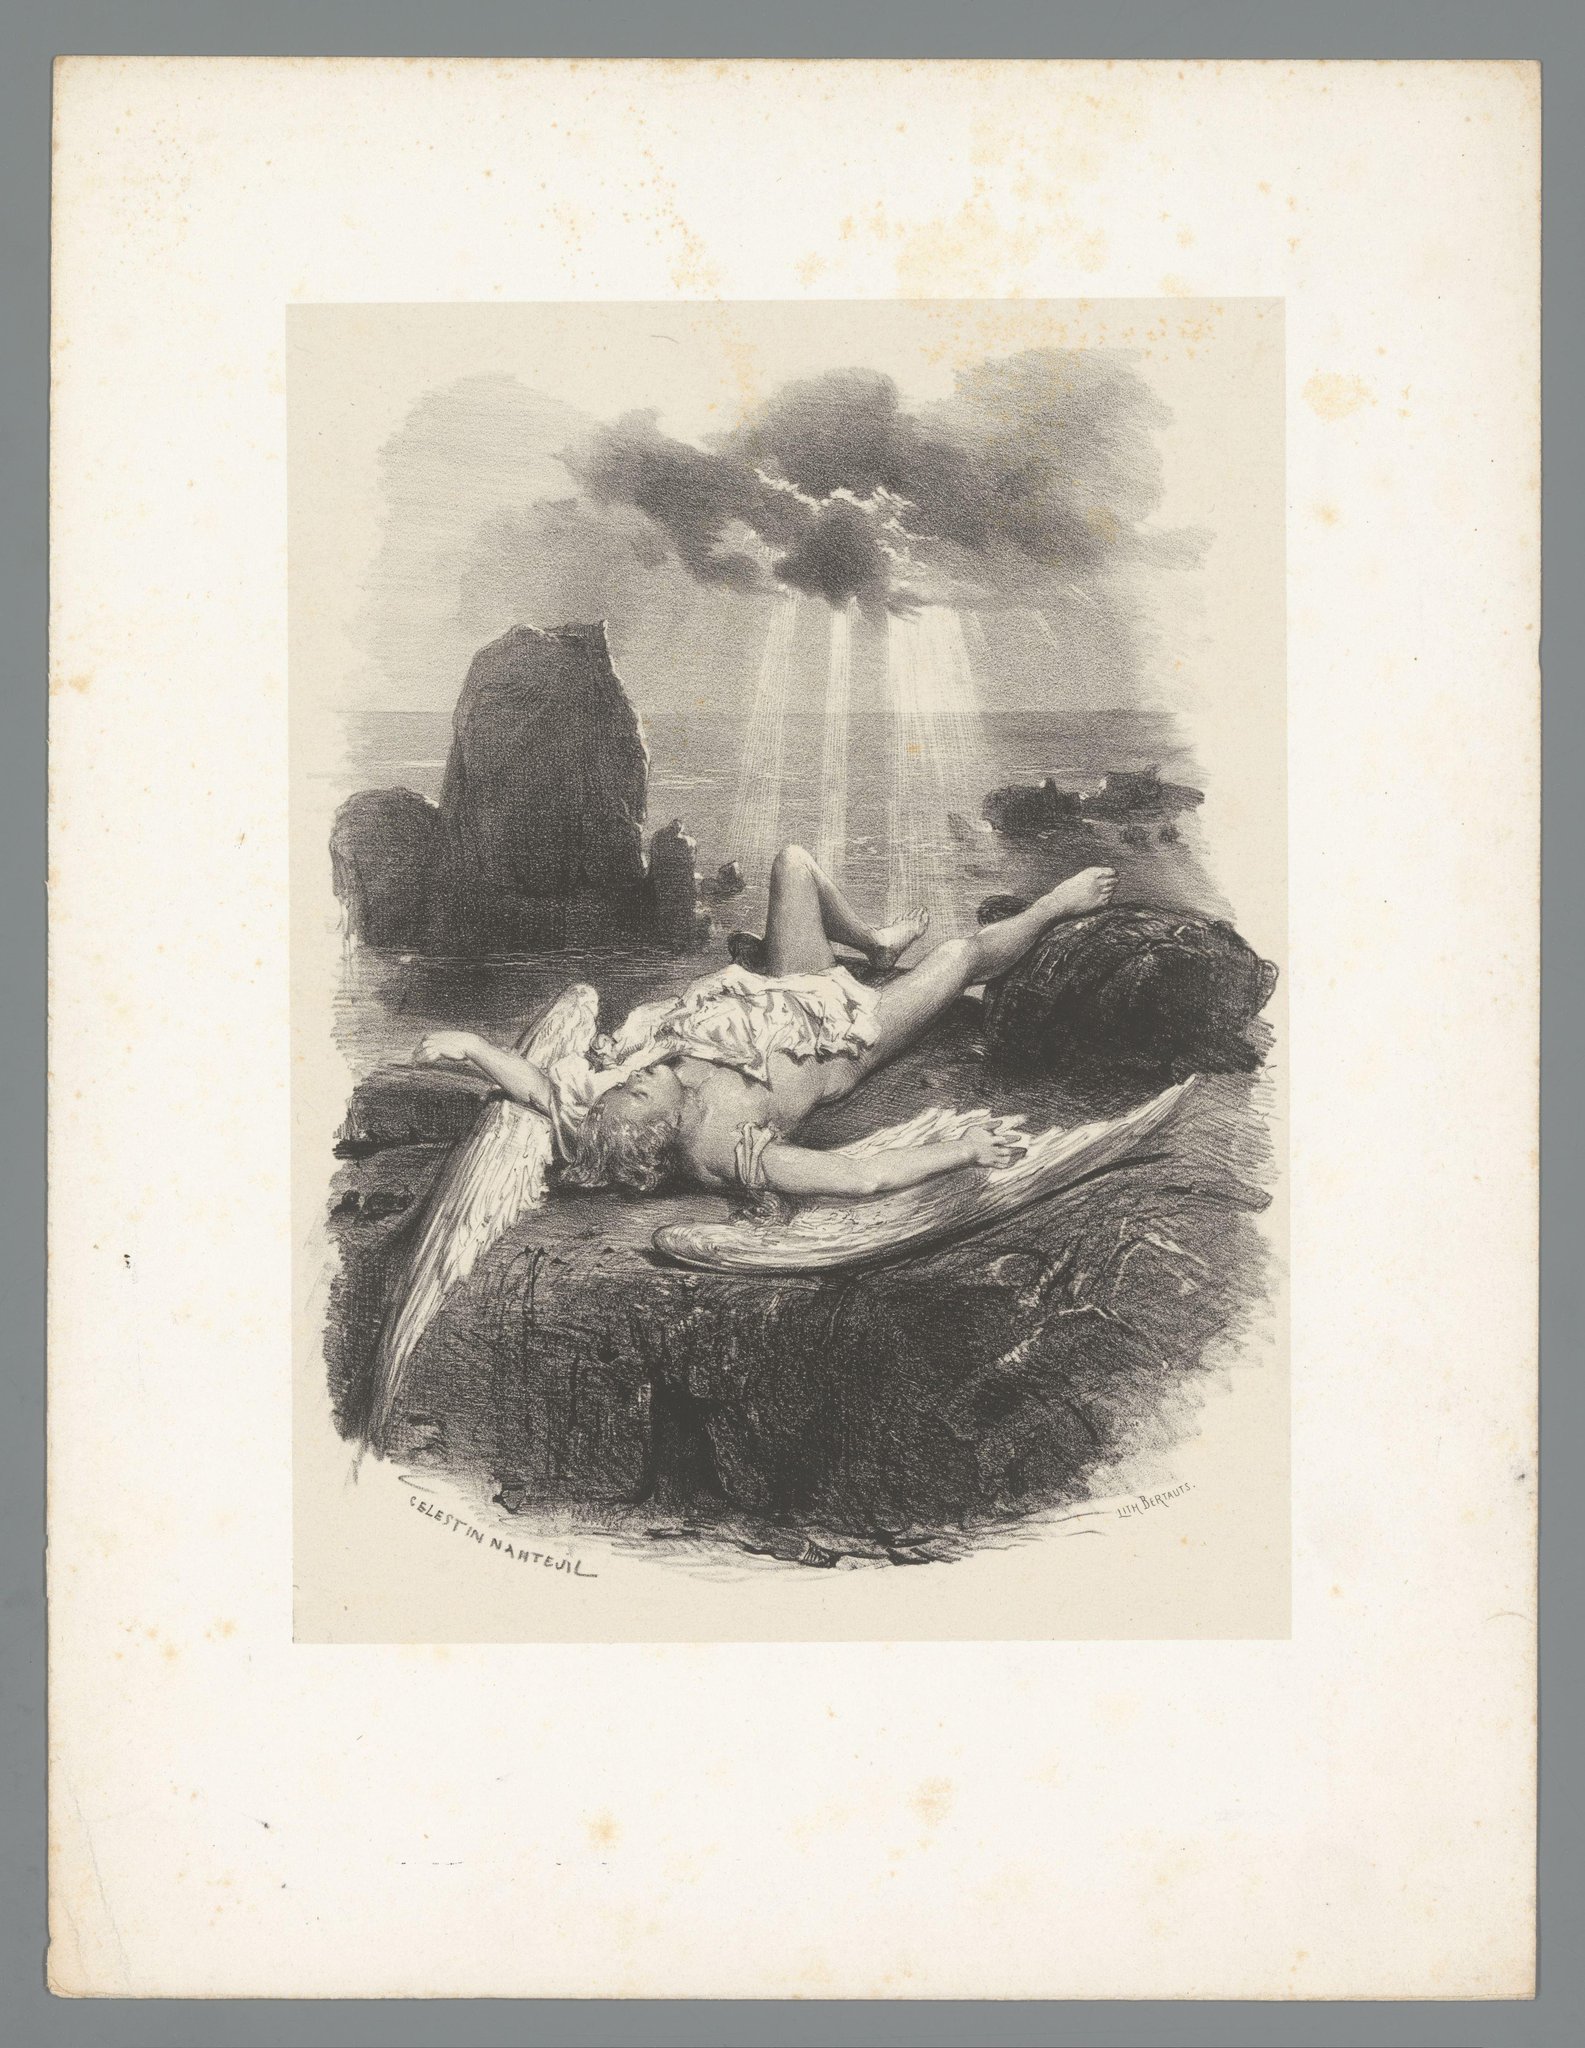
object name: print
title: Icarus met gebroken vleugels liggend op een rots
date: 1826-1880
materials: paper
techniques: lithograph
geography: paris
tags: sunbeams, fabulous beings with wings, angels, sea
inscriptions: collector's mark: Lugt 964